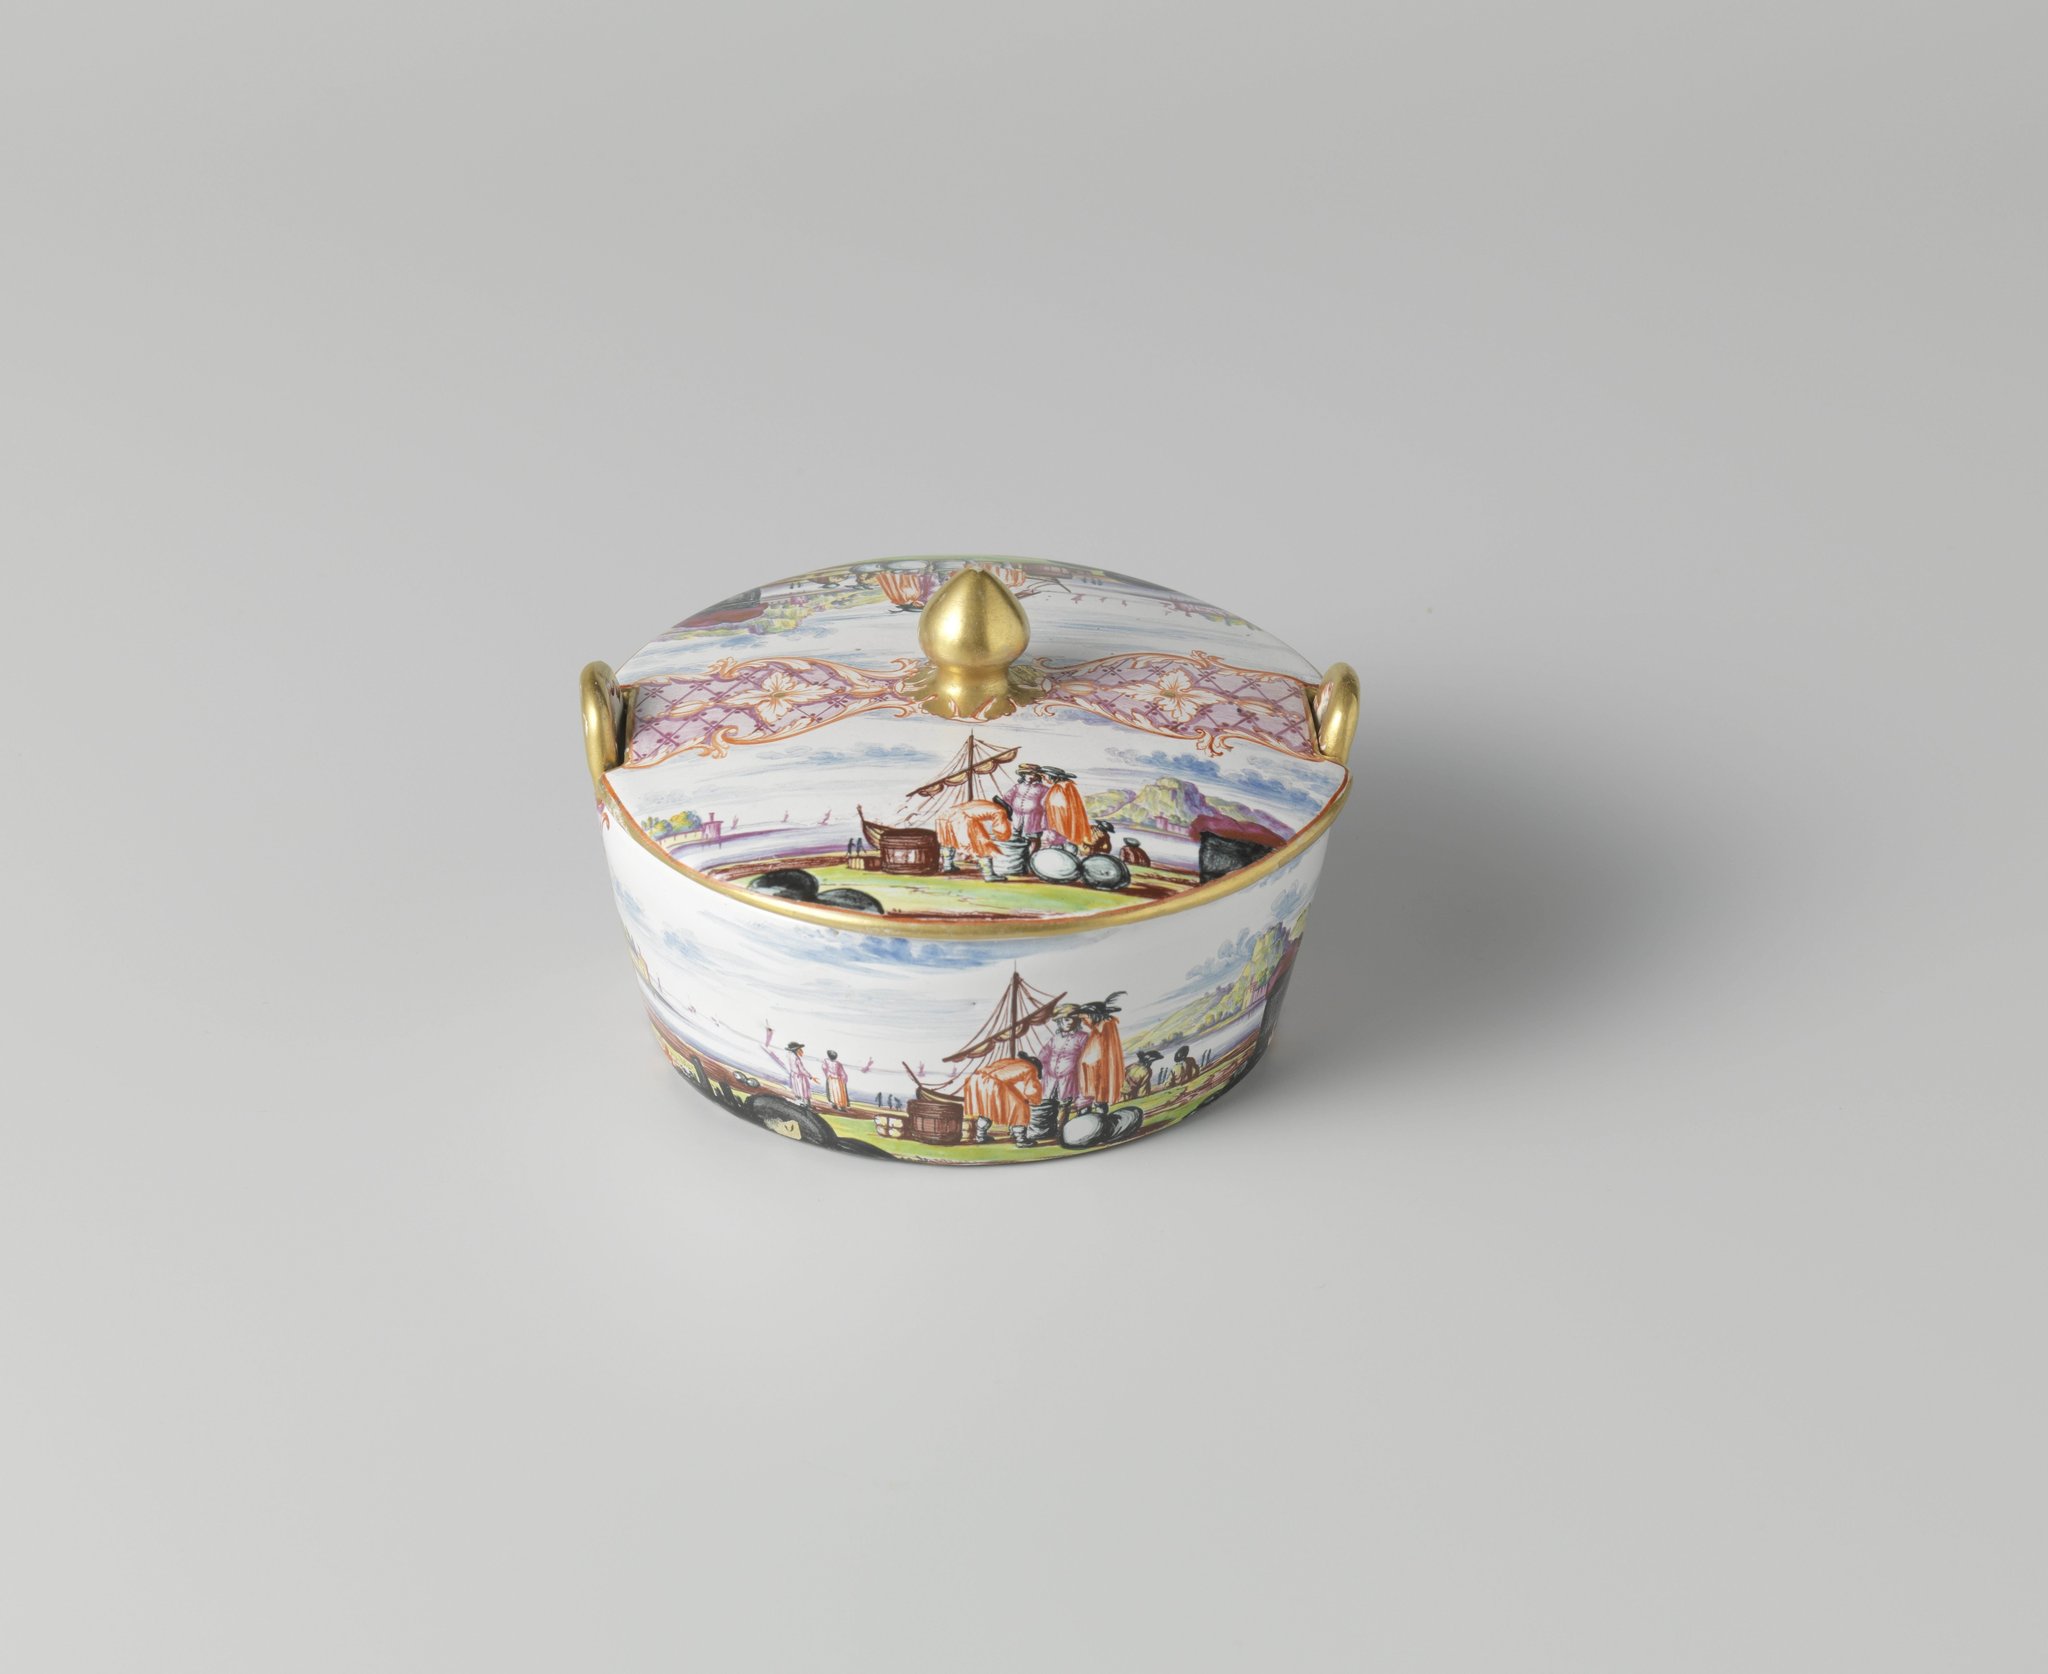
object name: lid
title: Deksel van botervloot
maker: Anonymous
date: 1735-1755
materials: faience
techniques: kiln, painted, polychromy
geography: delft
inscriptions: mark: ‘VA’, inscription: ‘9’, collector's mark: ‘collection J.F. Loudon’, inscription: ‘9’